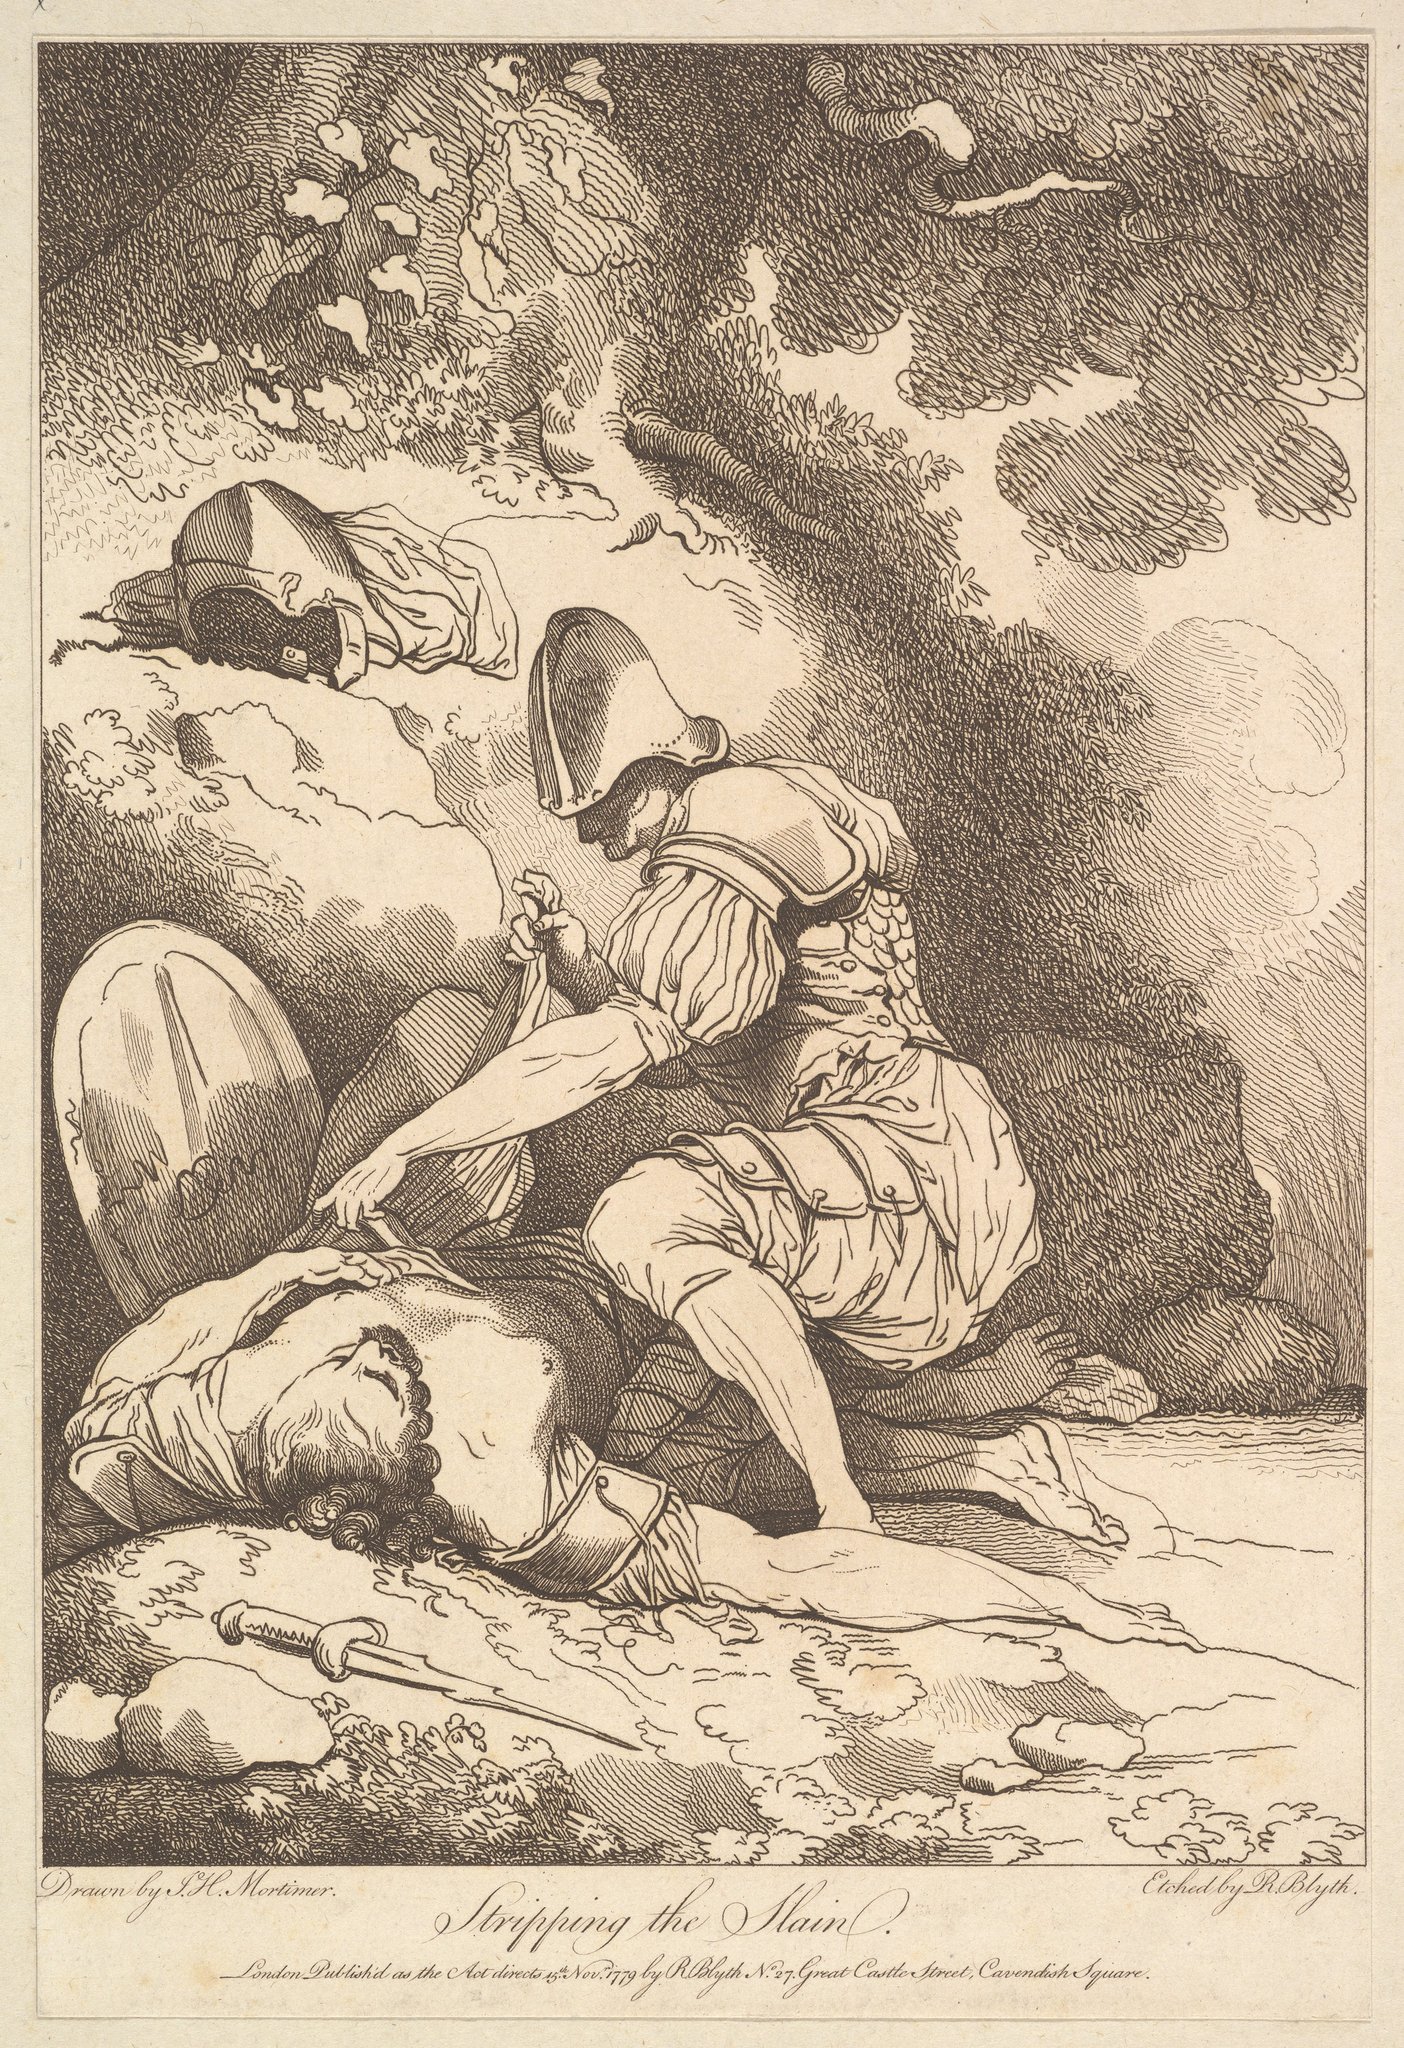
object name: print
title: Stripping the Slain, from "Banditti Variously Employed"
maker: robert blyth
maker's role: artist and publisher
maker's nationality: british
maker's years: 1750-1784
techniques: etching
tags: soldiers,knives,death